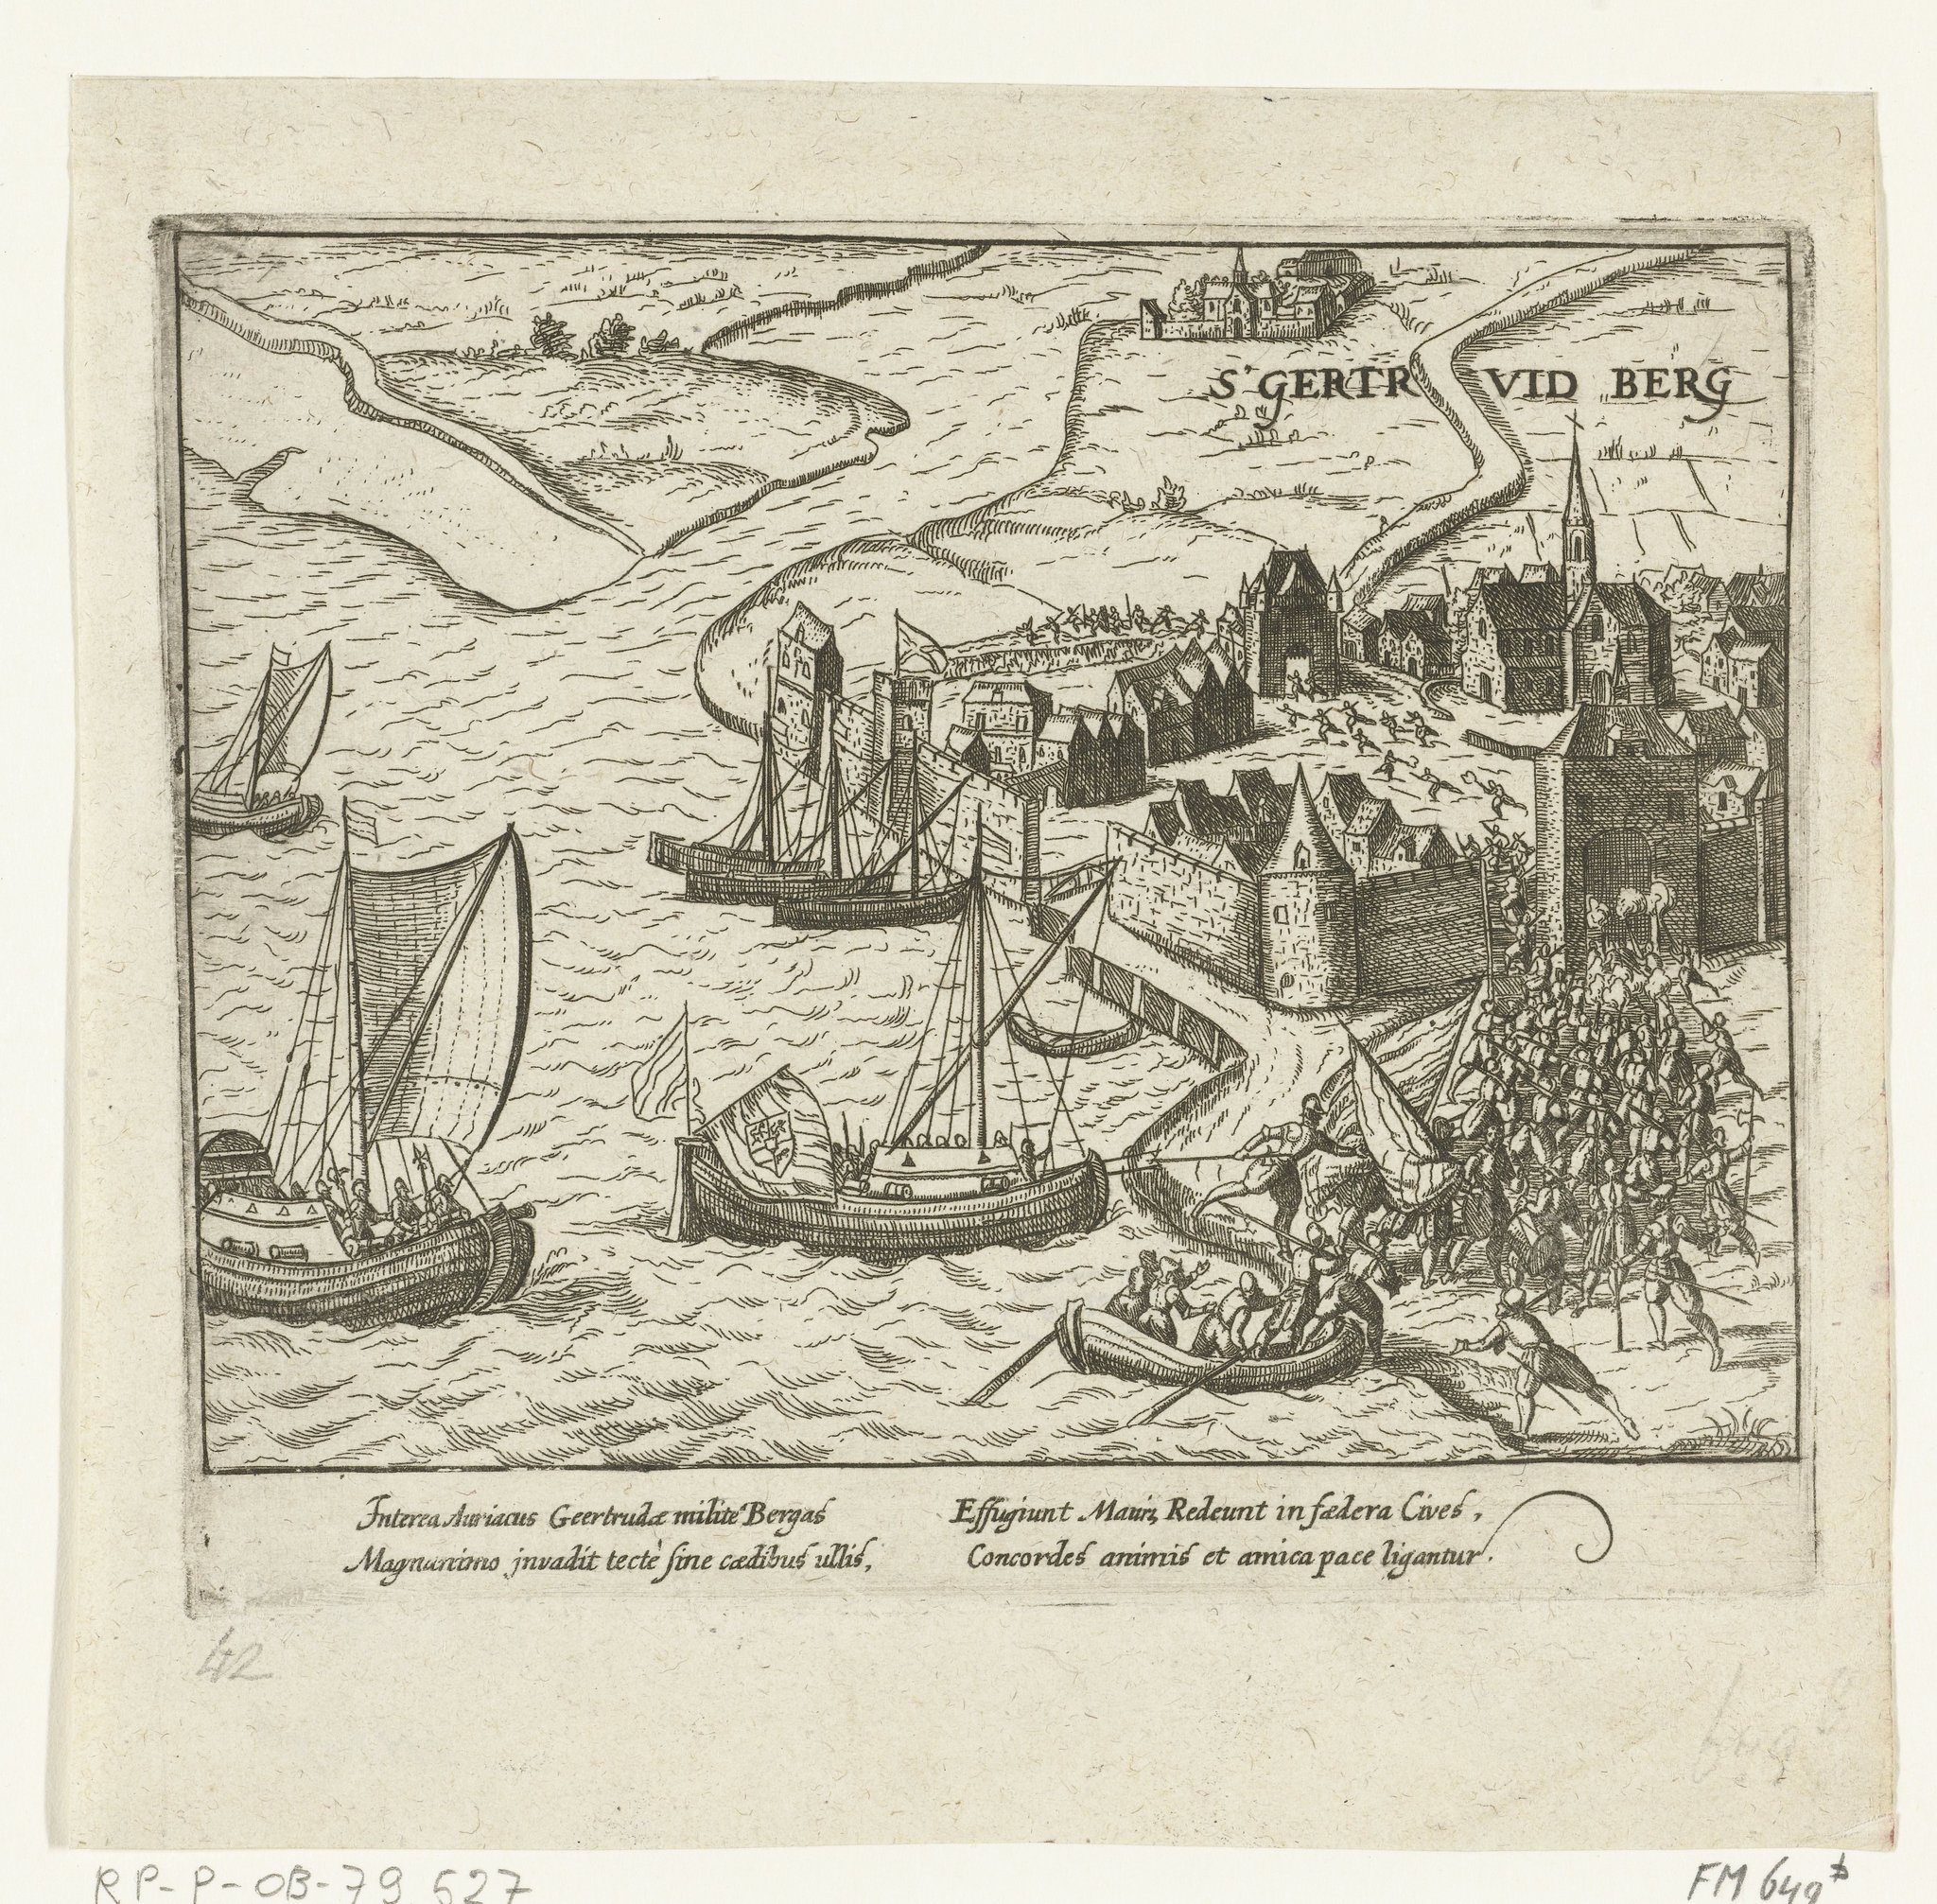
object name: print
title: Inname van Geertruidenberg, 1573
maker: Anonymous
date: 1613-1615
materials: paper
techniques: etching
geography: northern netherlands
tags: capture of city (after the siege), geertruidenberg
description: Inname van Geertruidenberg door de watergeuzen op 28 augustus 1573. Soldaten komen op de voorgrond aan land en bestormen de stad. In het water enkele kleine schepen met vlaggen. Met onderschrift van 4 regels in het Latijn. Genummerd: 42. De achterzijde onbedrukt.